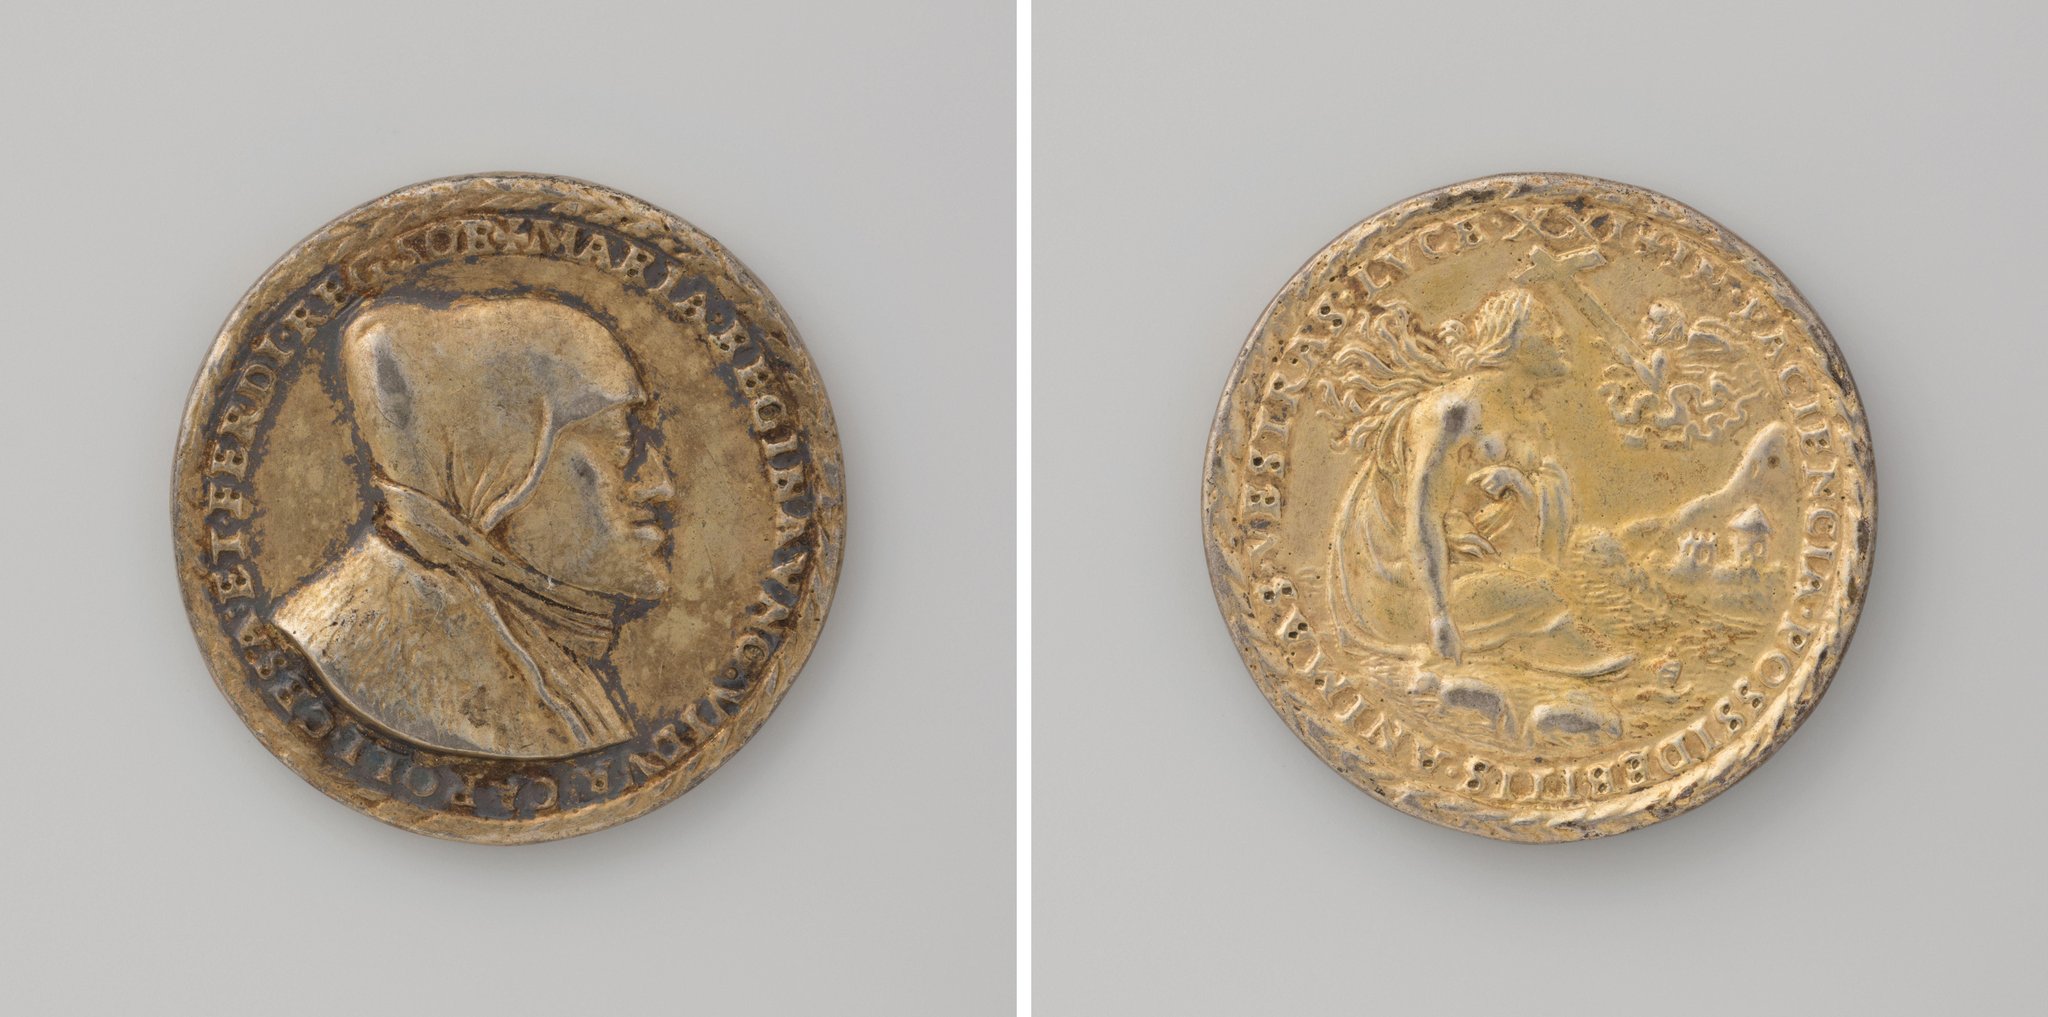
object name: history medal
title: Maria van Hongarije, landvoogdes der Nederlanden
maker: ludwig neufahrer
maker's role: die cutter, goldsmith, mintmaster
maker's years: 1500-1563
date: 1536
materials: silver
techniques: gilding, striking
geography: germany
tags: brussels, maria van hongarije (landvoogdes der nederlanden)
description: Zilveren penning. Voorzijde: borststuk vrouw binnen omschrift en bladerkrans. Keerzijde: zittende vrouw in landschap; aan haar voeten twee lammetjes, boven haar engel met kruis binnen omschrift en bladerkrans